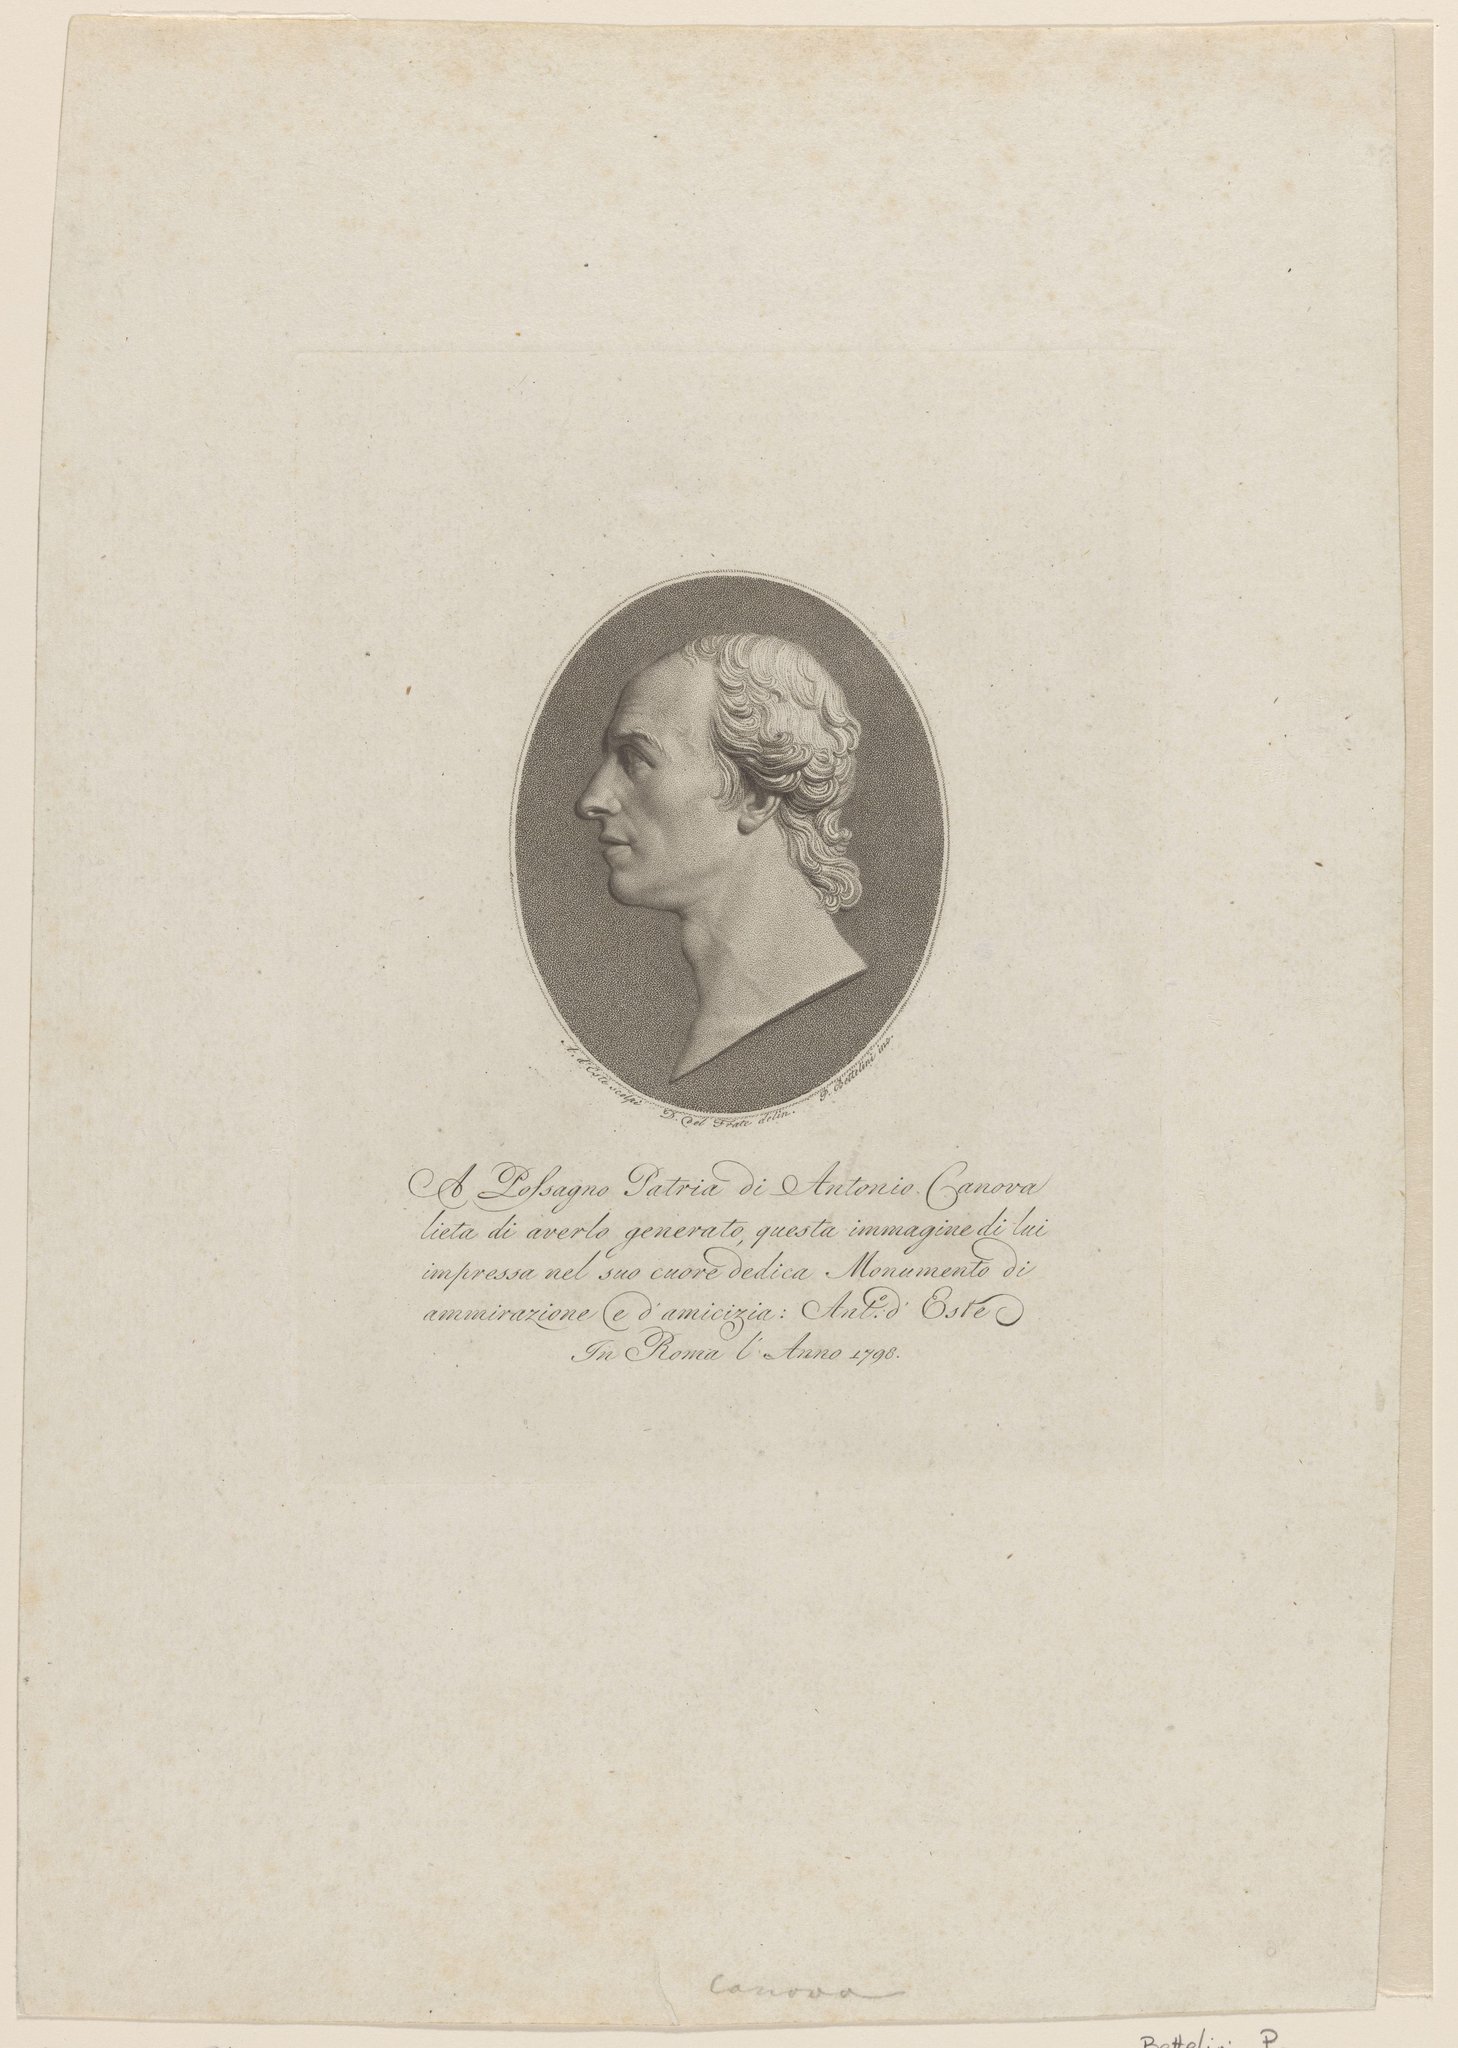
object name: print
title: Portret en-profil van Antonio Canova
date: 1798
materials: paper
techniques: engraving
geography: rome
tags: venice, sculptor, antonio canova, portrait, self-portrait of sculptor, historical persons, portrait, self-portrait of artist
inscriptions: collector's mark: Lugt 2228, collector's mark: Lugt 2760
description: Portret van de beeldhouwer Antonio Canova, naar een portret in reliëf in profiel naar links, door Antonio d'Este.